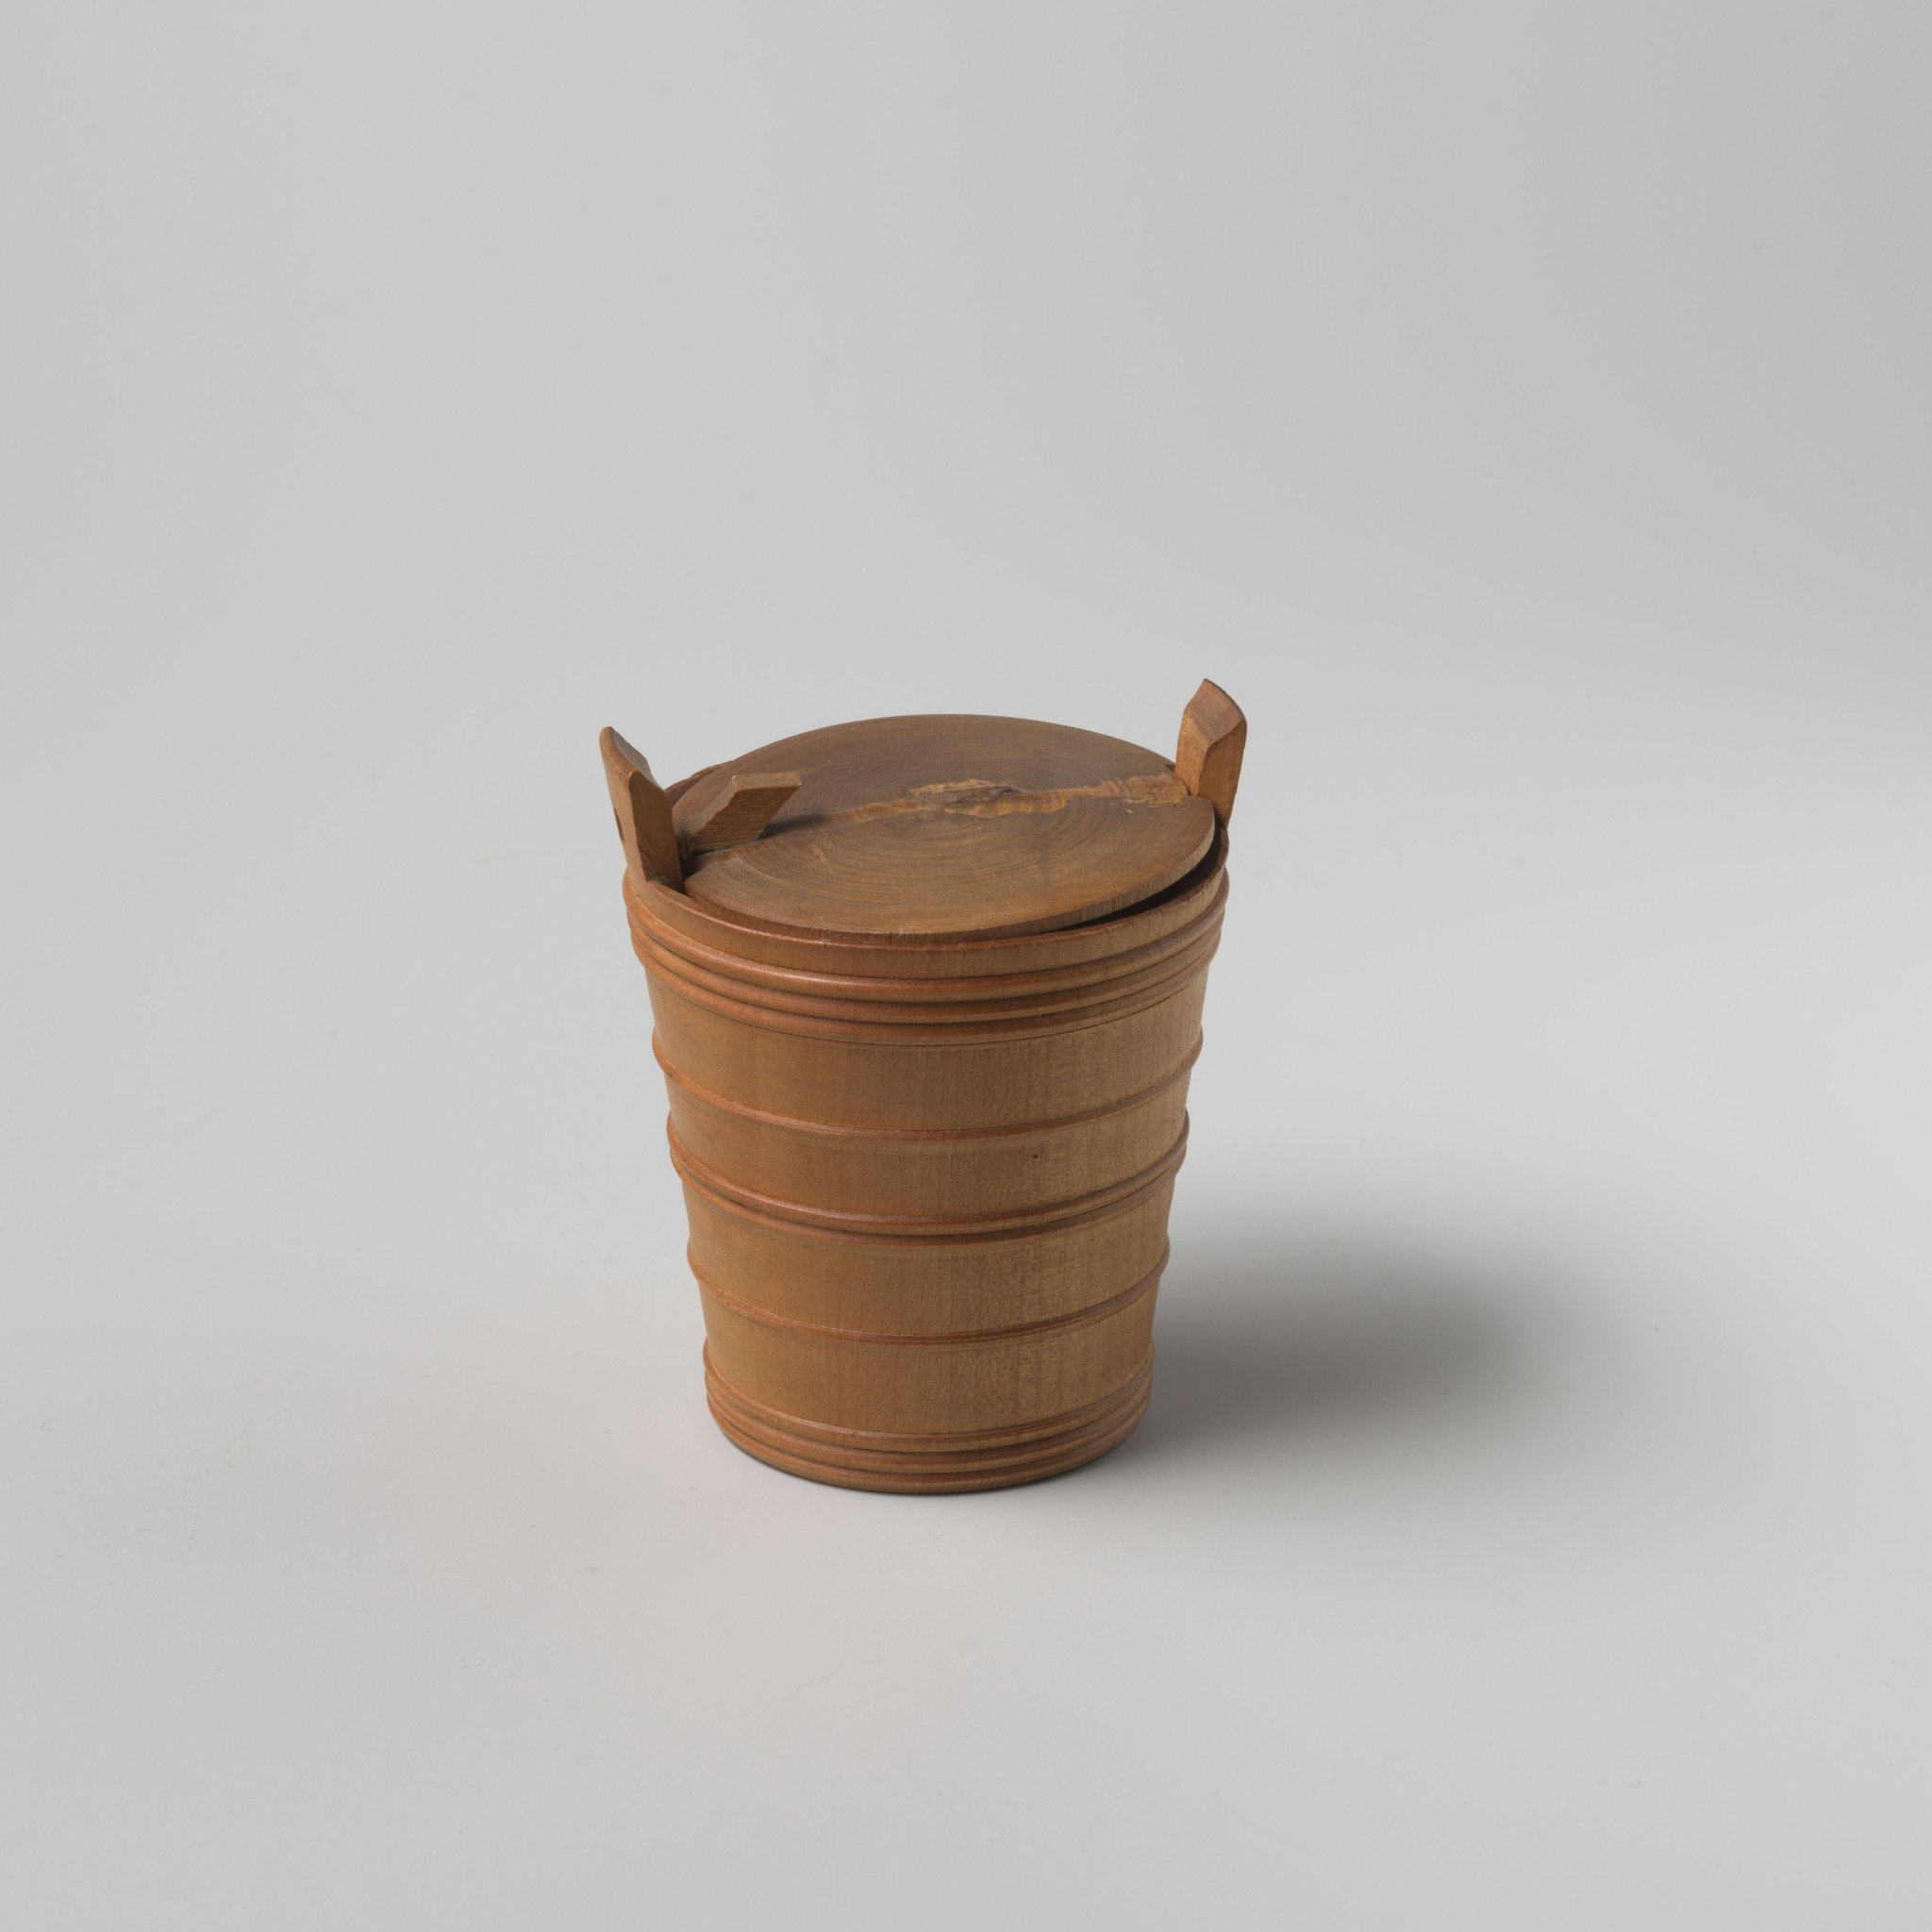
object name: salting tub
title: Vleeskuip van esdoornhout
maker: Anonymous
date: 1676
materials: wood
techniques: turning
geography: amsterdam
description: Vleeskuip, gedraaid van esdoornhout, met ringen (hoepels voorstellende). Op de rand twee rechtopstaande uitsteeksels, waartussen een deksel past met opgezette asymmetrische handgreep.